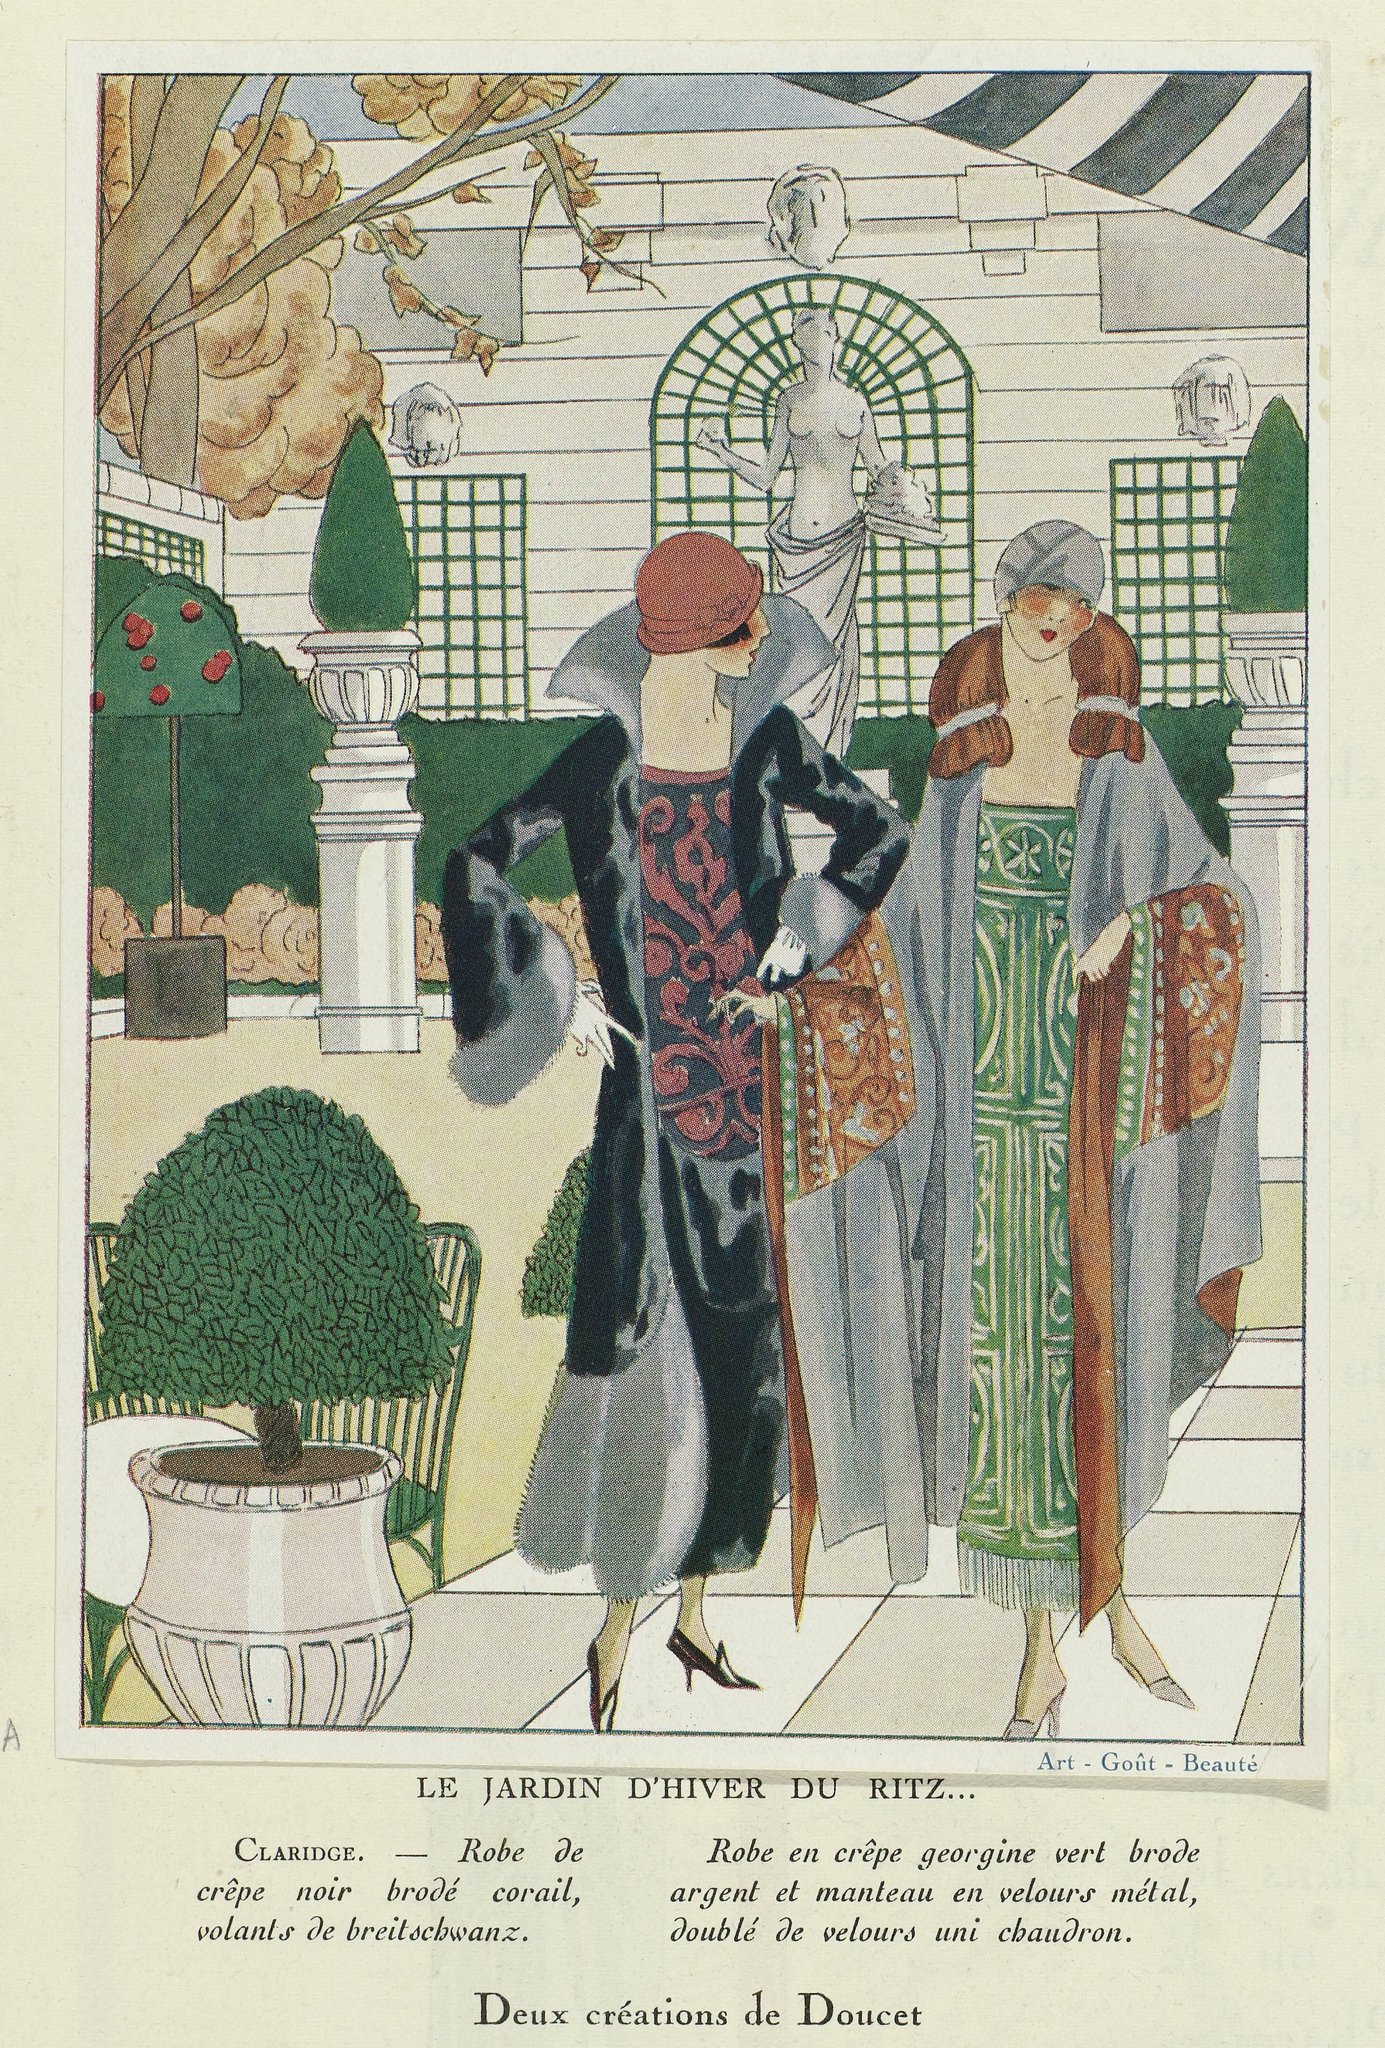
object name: fashion print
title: Art - Goût - Beauté, Feuillets de l' élégance féminine, Janvier 1924, No. 41, 4e Année, p. 6: Le Jardin d'Hiver du Ritz (...)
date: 1924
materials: paper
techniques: printing, lithograph, photography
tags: border, ribbon, braid (+ fur used for clothes), coat (+ women's clothes), garden, fashion plates, dress, gown (+ women's clothes)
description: De wintertuin in het Ritz in 1924. Japonnen en mantels van Doucet. Deel van een pagina uit het modetijdschrift Art-Goût-Beauté (1920-1933).